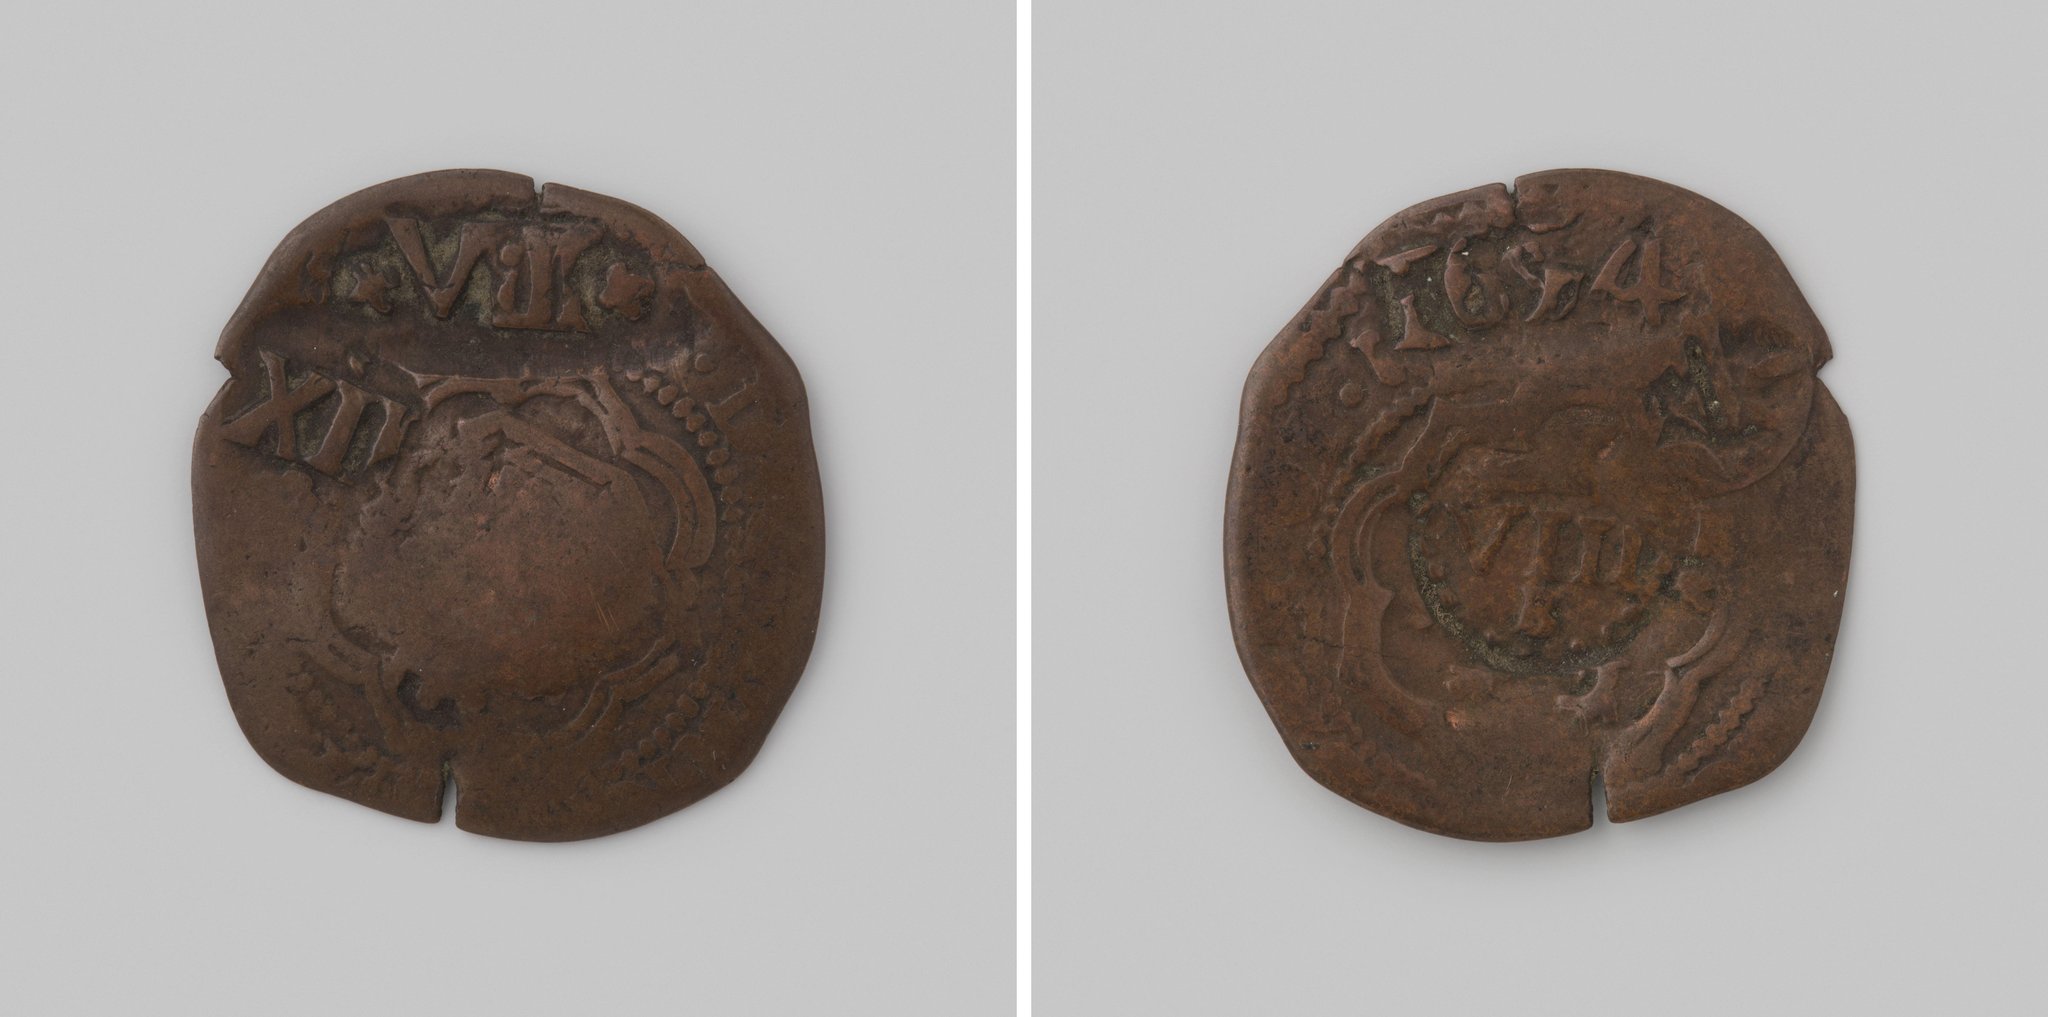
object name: coin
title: 12 maravedis uit Spanje van koning Philips IV, 1634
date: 1663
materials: copper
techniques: striking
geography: madrid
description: Koperen munt, die is voorzien van een aantal instempelingen (kloppen), waardoor oorspronkelijke beeldenaar niet meer is te onderscheiden. Voorzijde: klop: VIII en XII. Keerzijde: klop: VIII, waaronder 8 en klop: 1634.